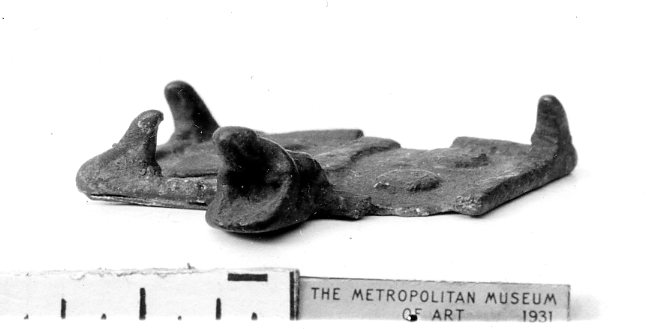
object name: miniature offering table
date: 400-200 BCE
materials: bronze, copper alloy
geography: egypt